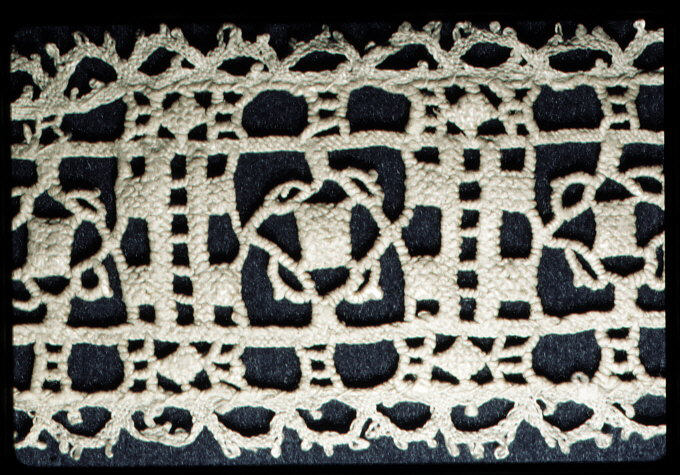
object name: fragment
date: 1601-1633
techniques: lace